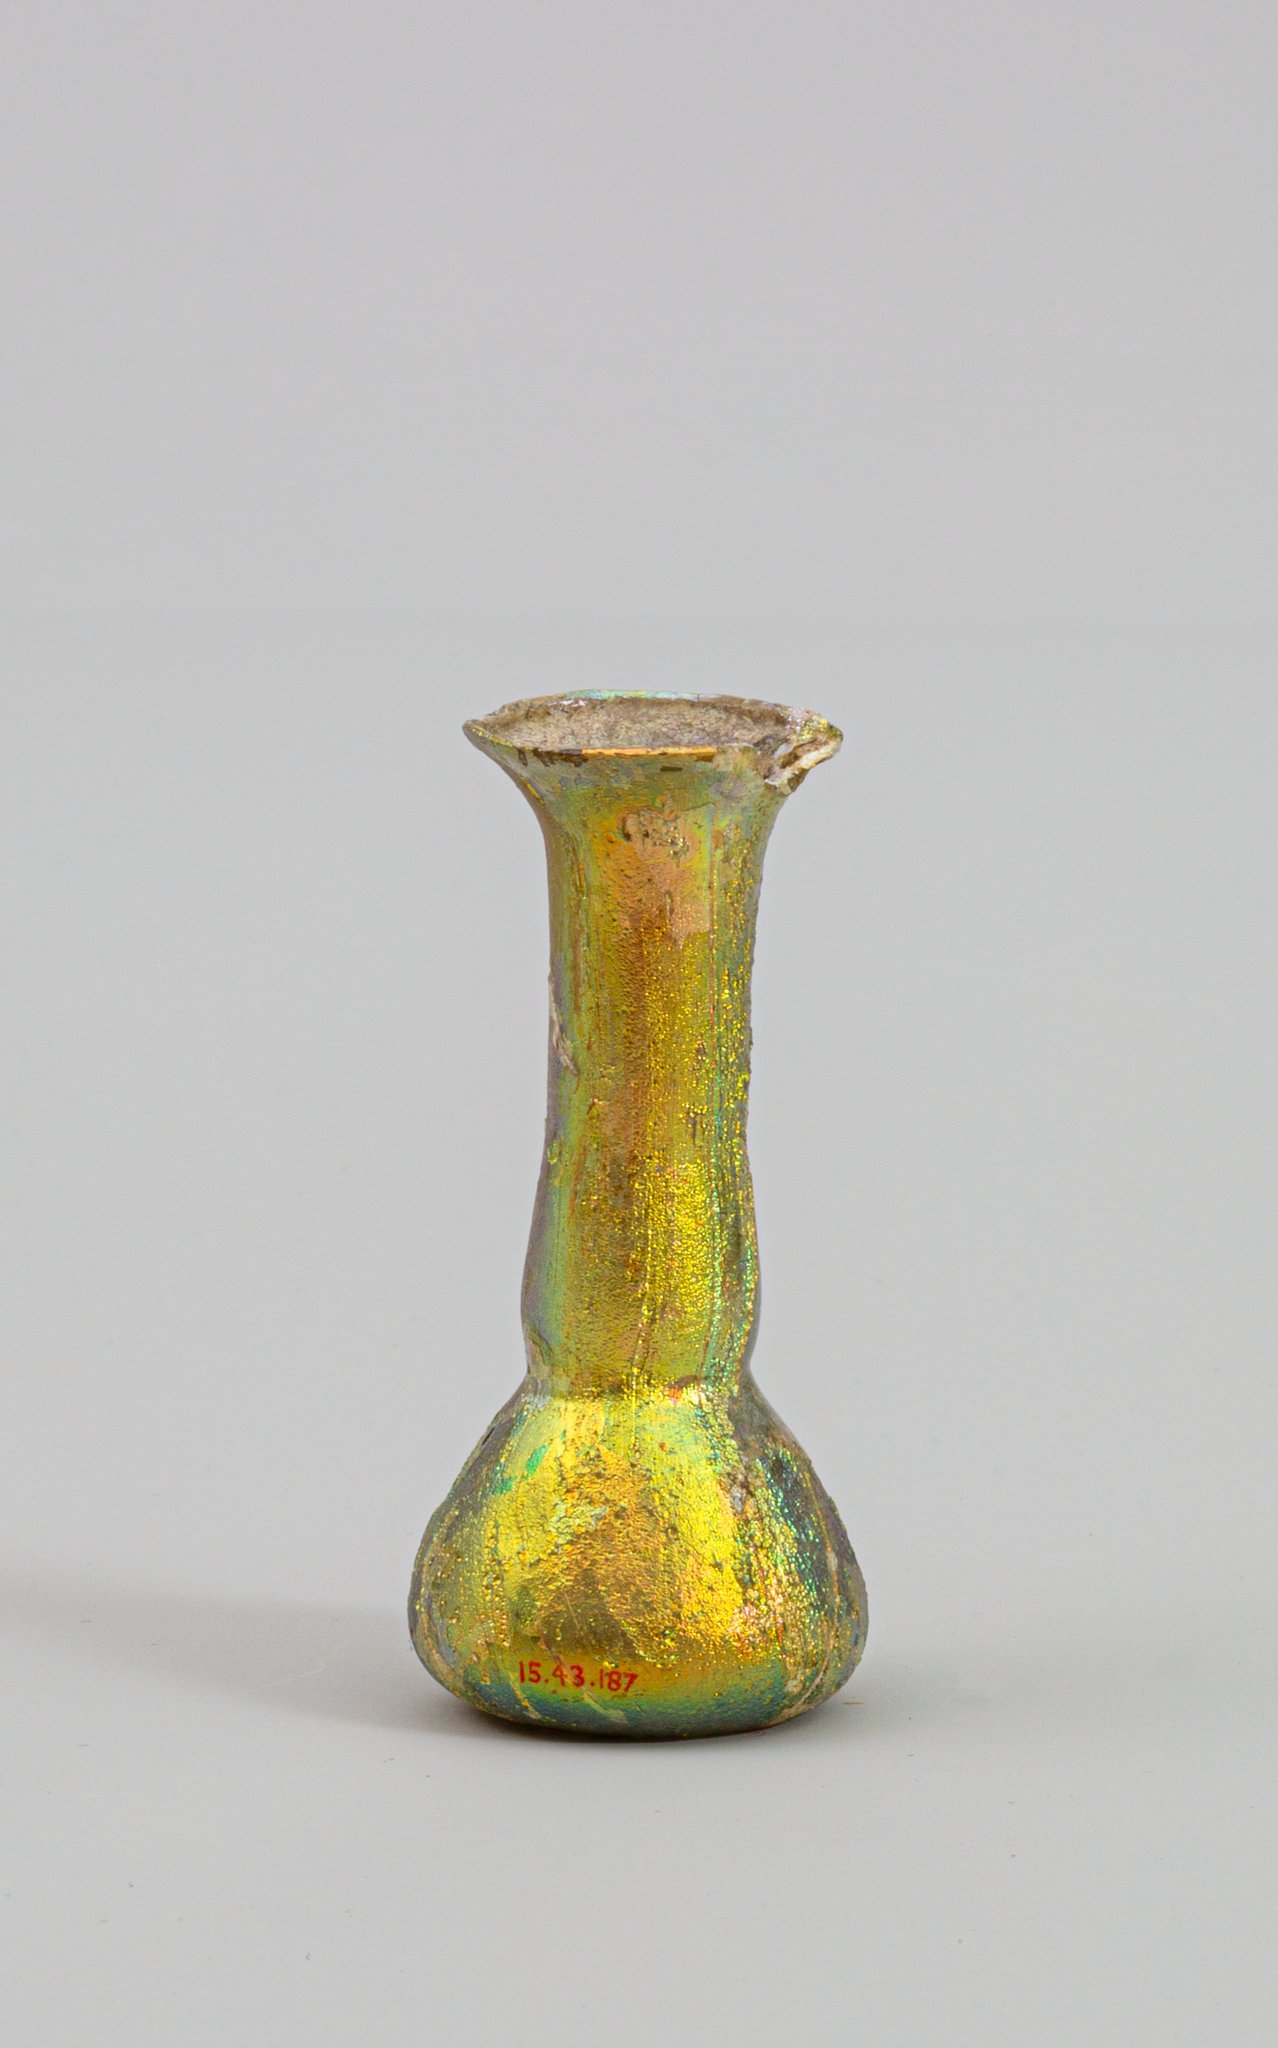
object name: perfume bottle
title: Glass perfume bottle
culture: roman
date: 67-300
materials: glass